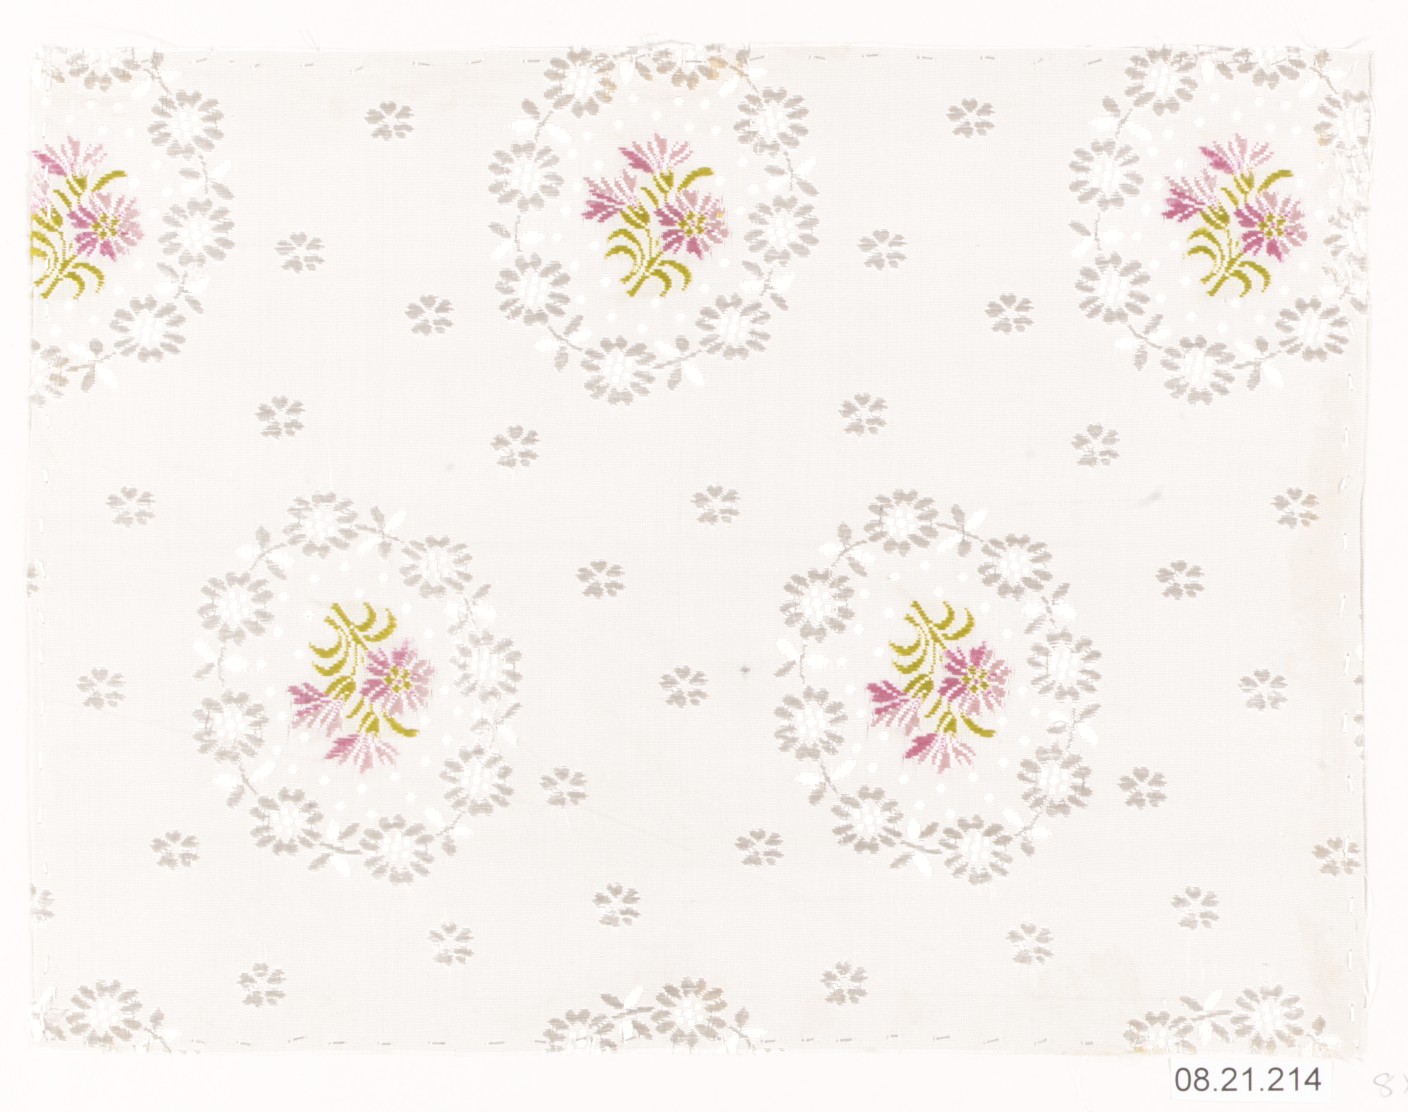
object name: textile sample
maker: Anonymous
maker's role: designer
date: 1900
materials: silk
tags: flowers